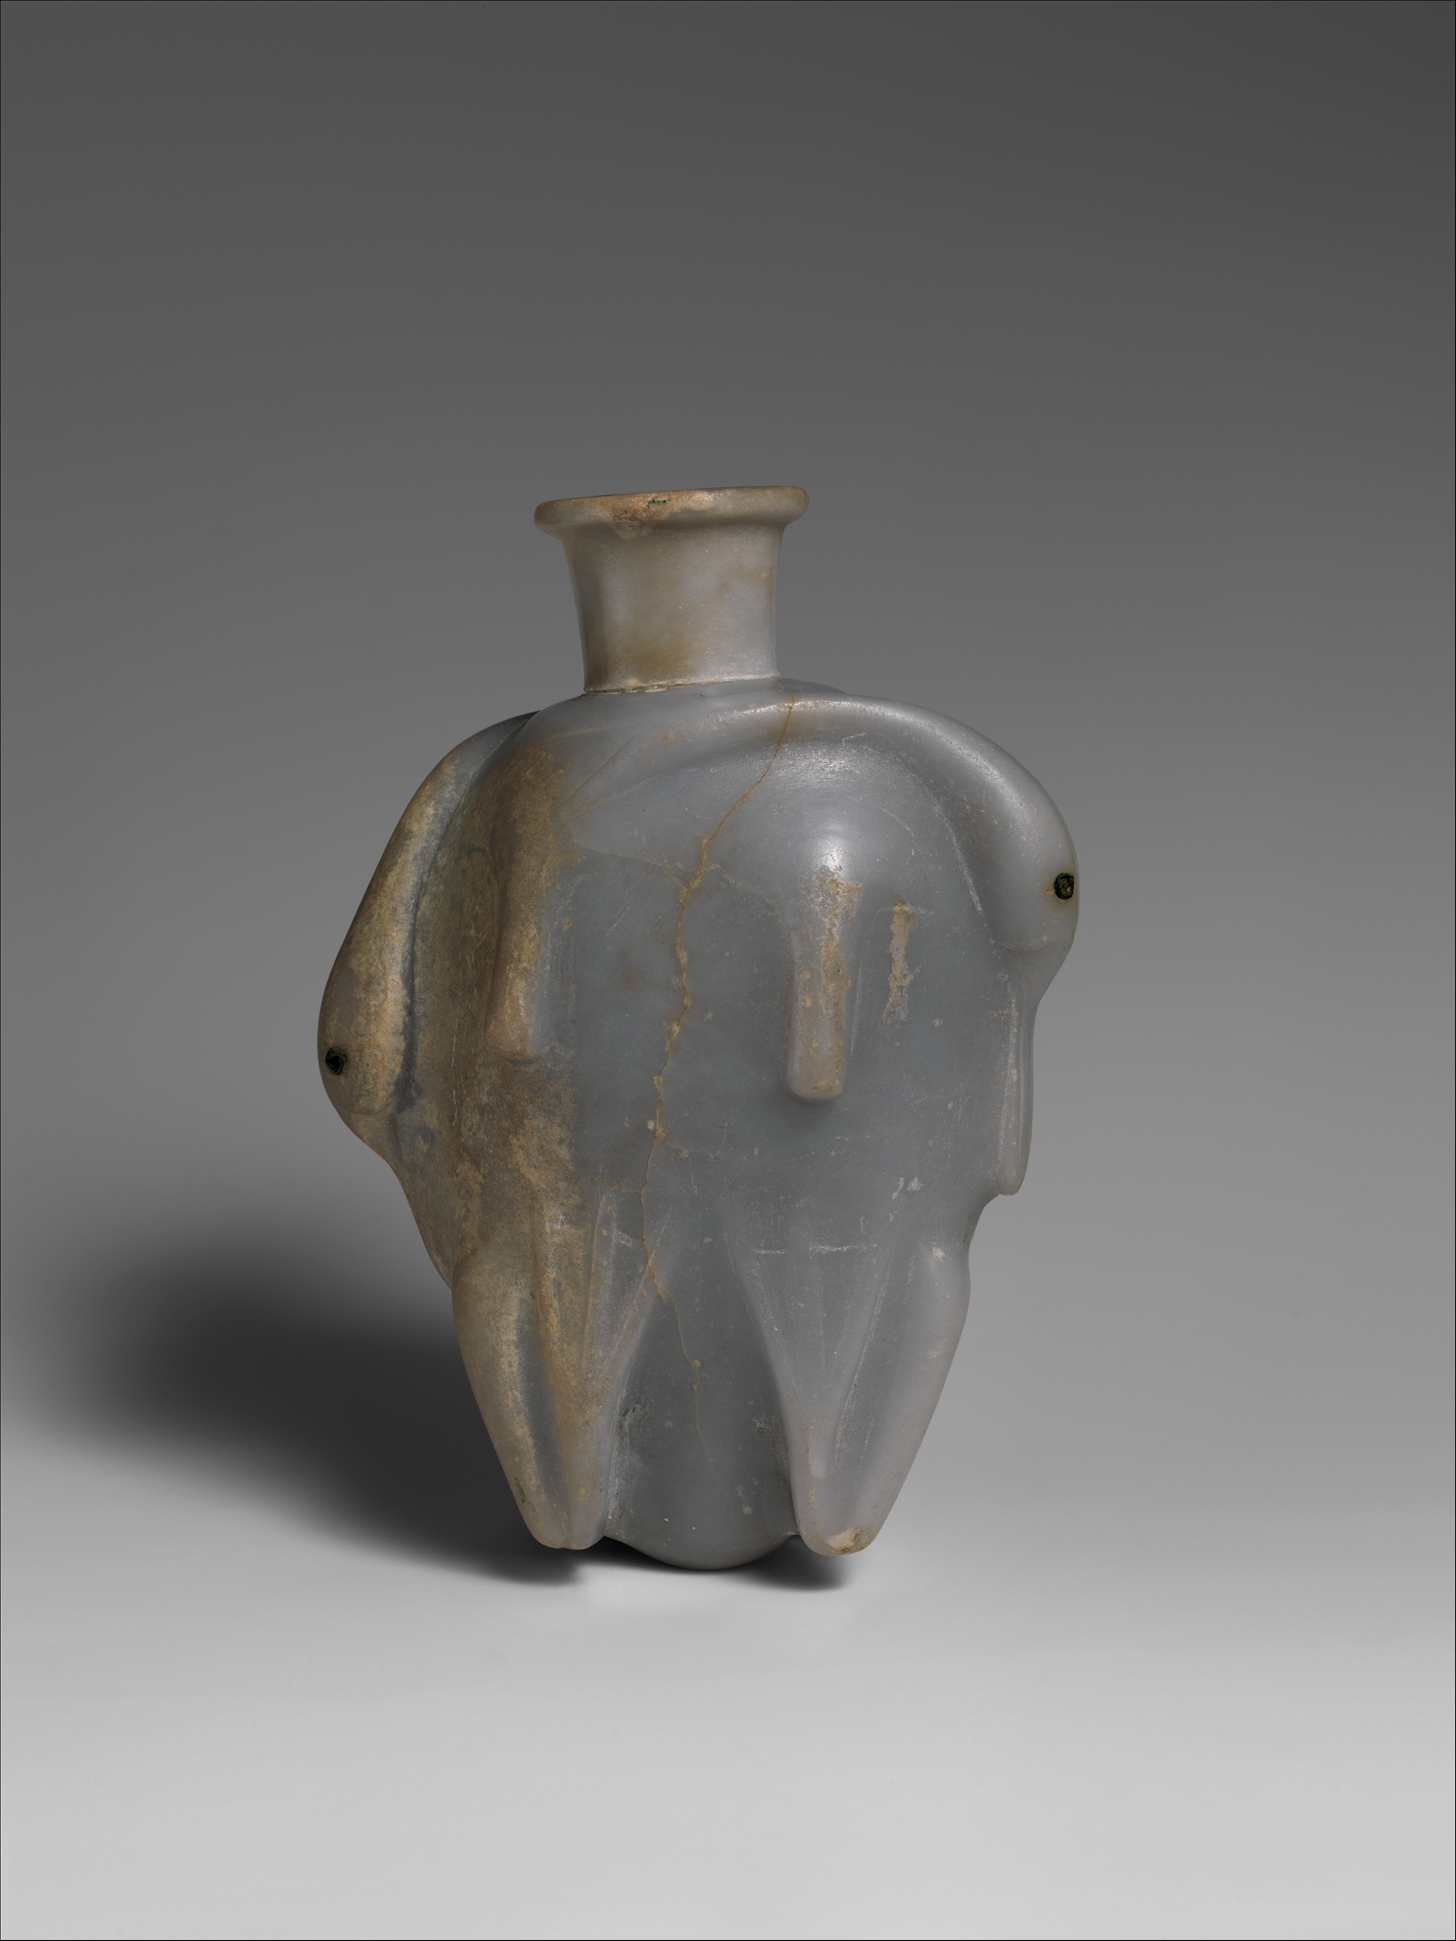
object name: vase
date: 1800-1550 BCE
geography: egypt